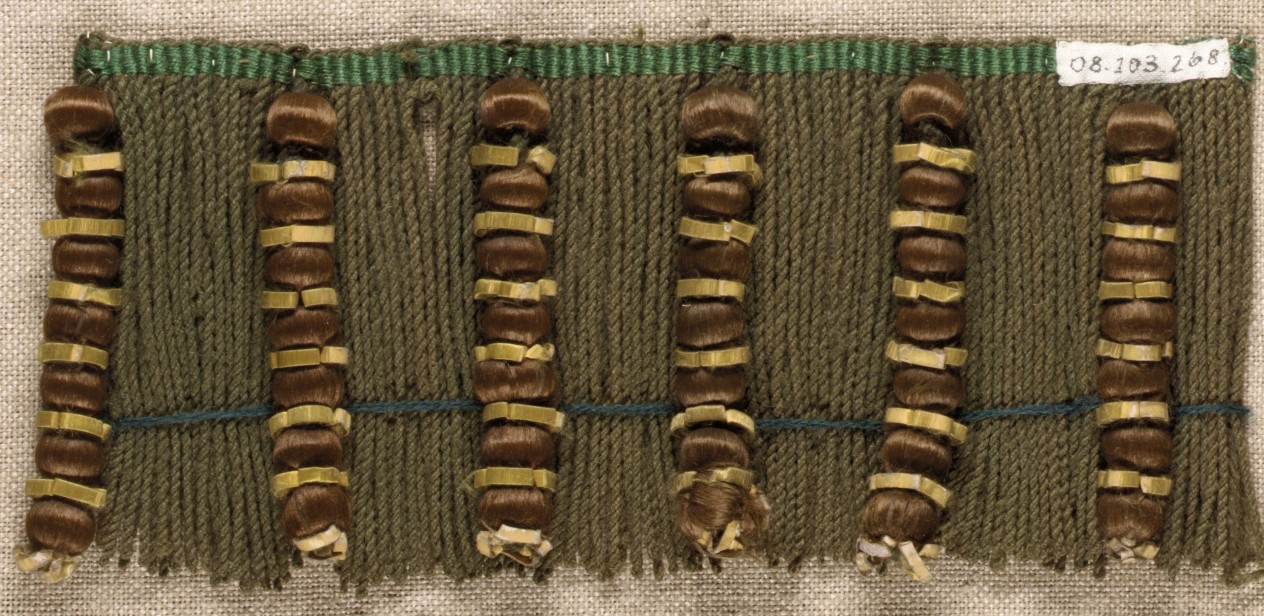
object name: fringe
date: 1801-1900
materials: cotton, silk